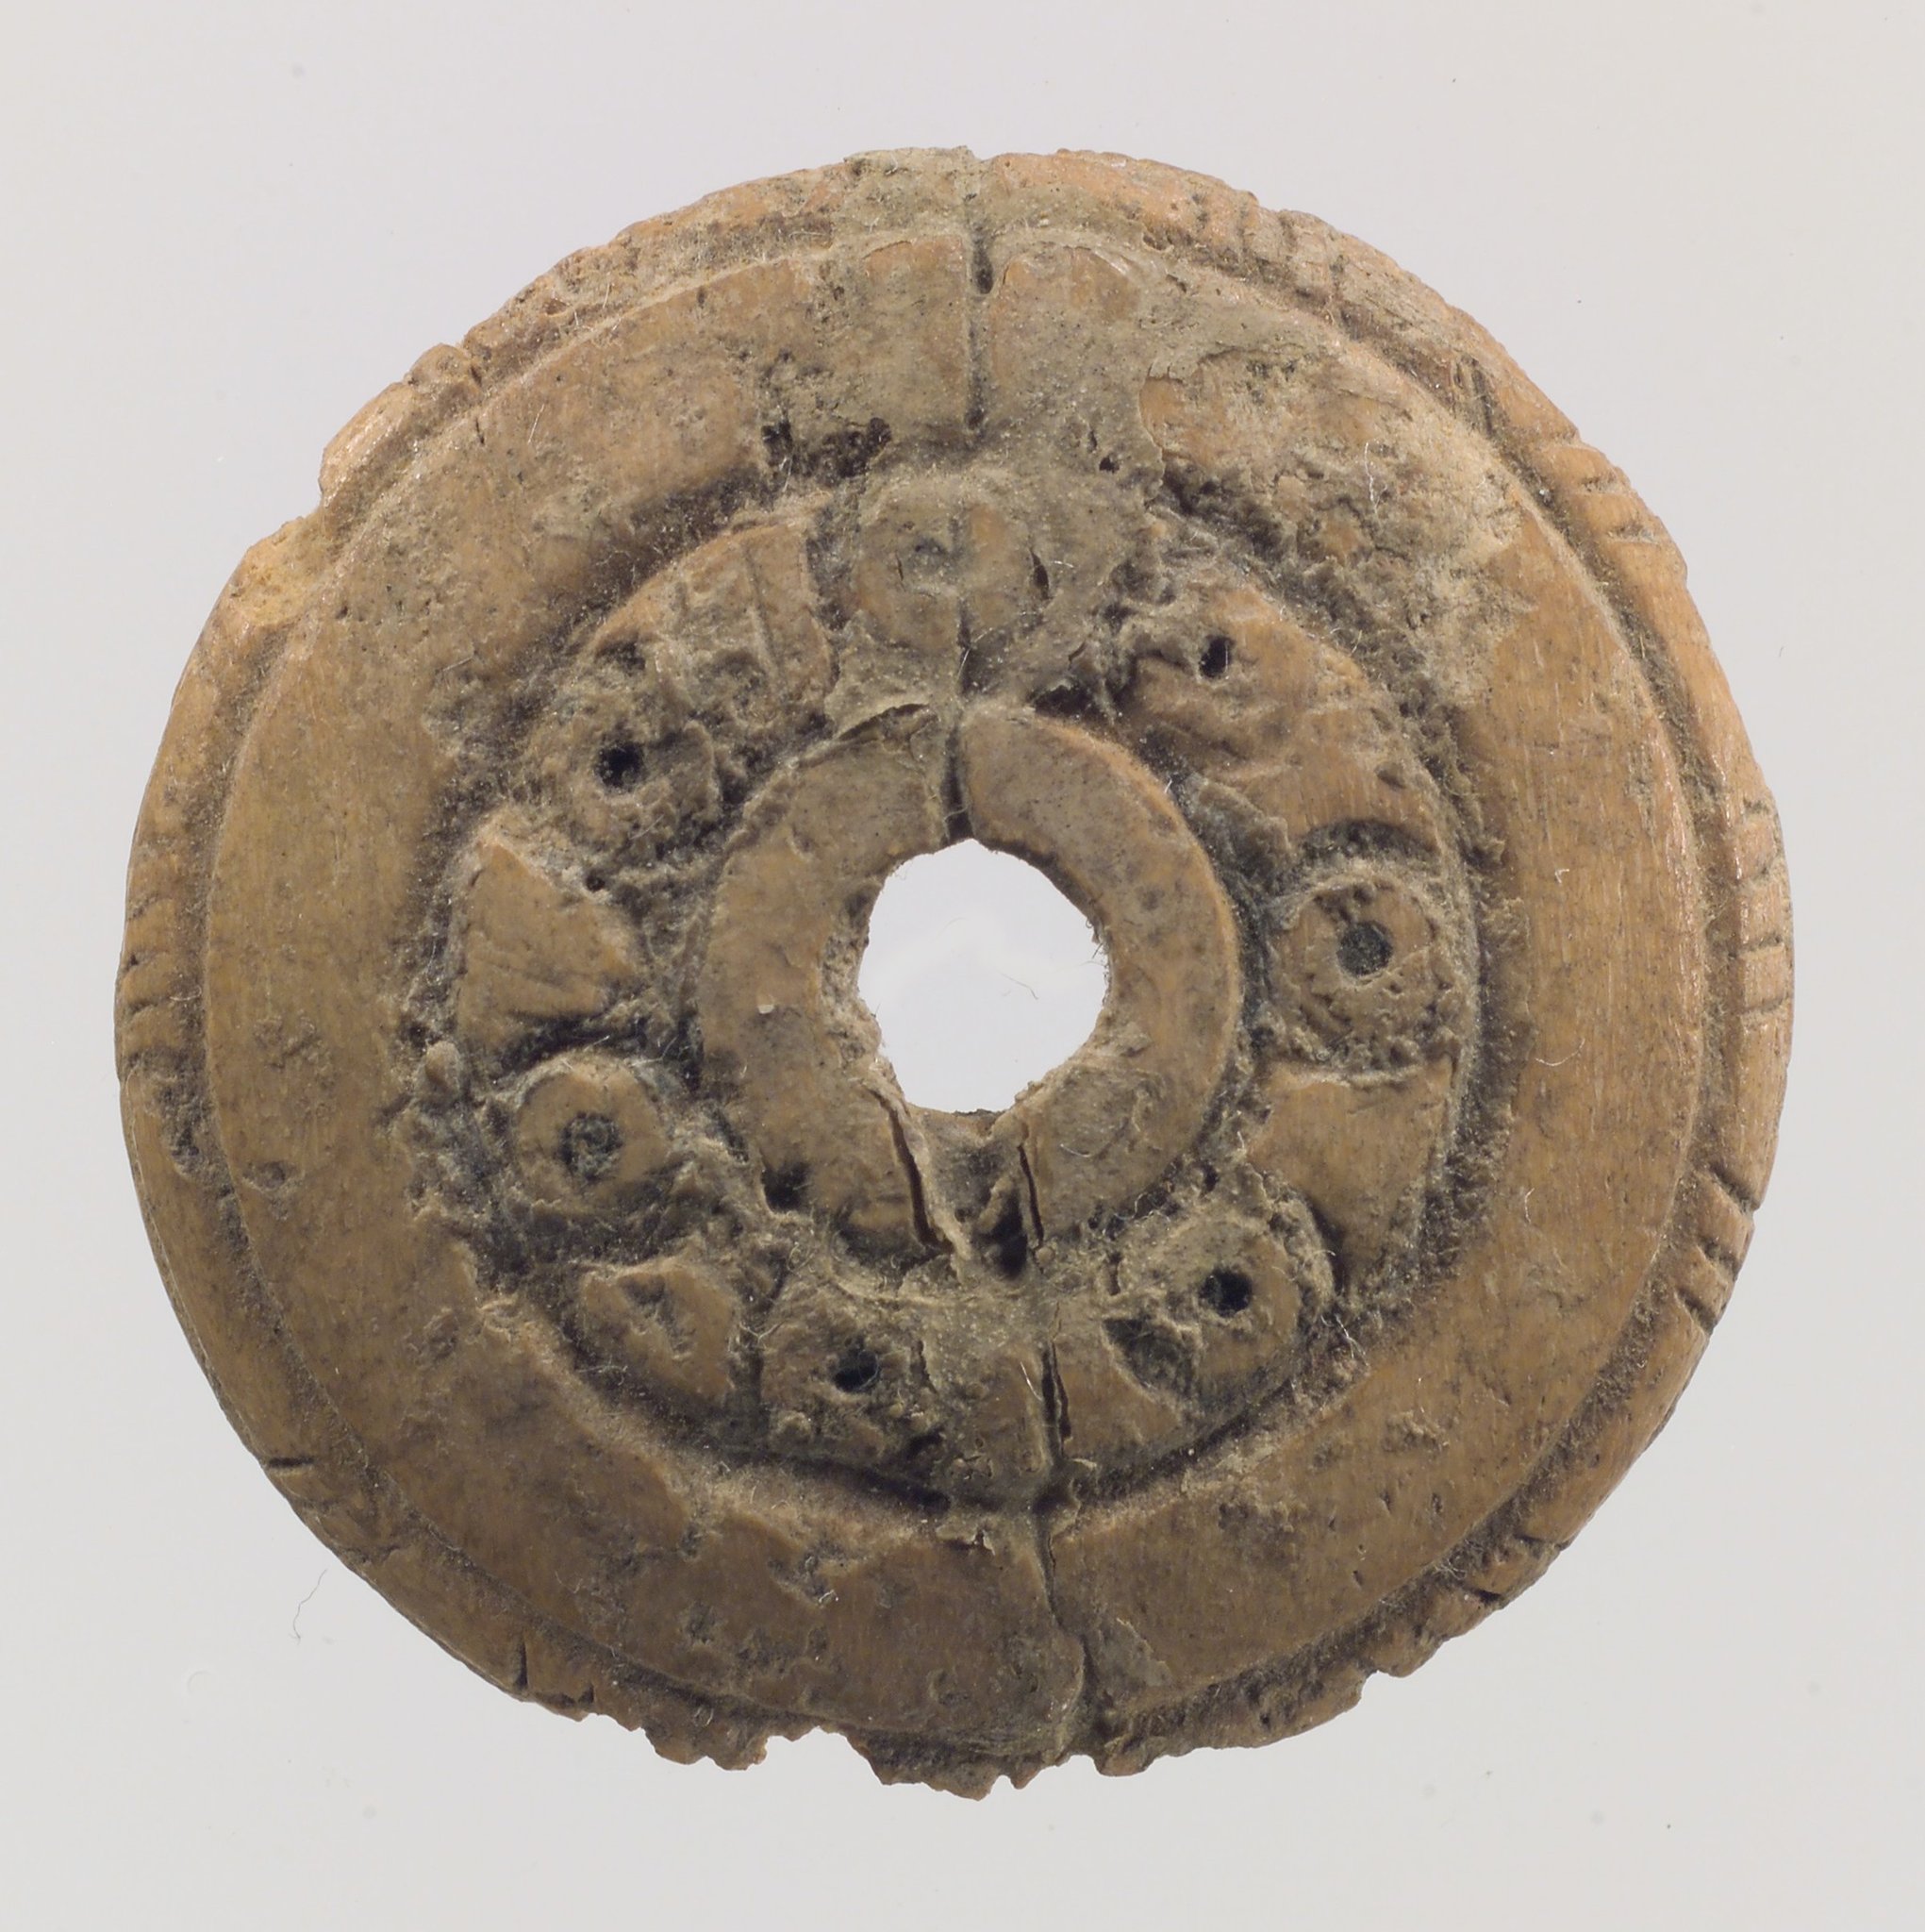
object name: button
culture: sasanian or islamic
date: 501-800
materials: bone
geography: iran